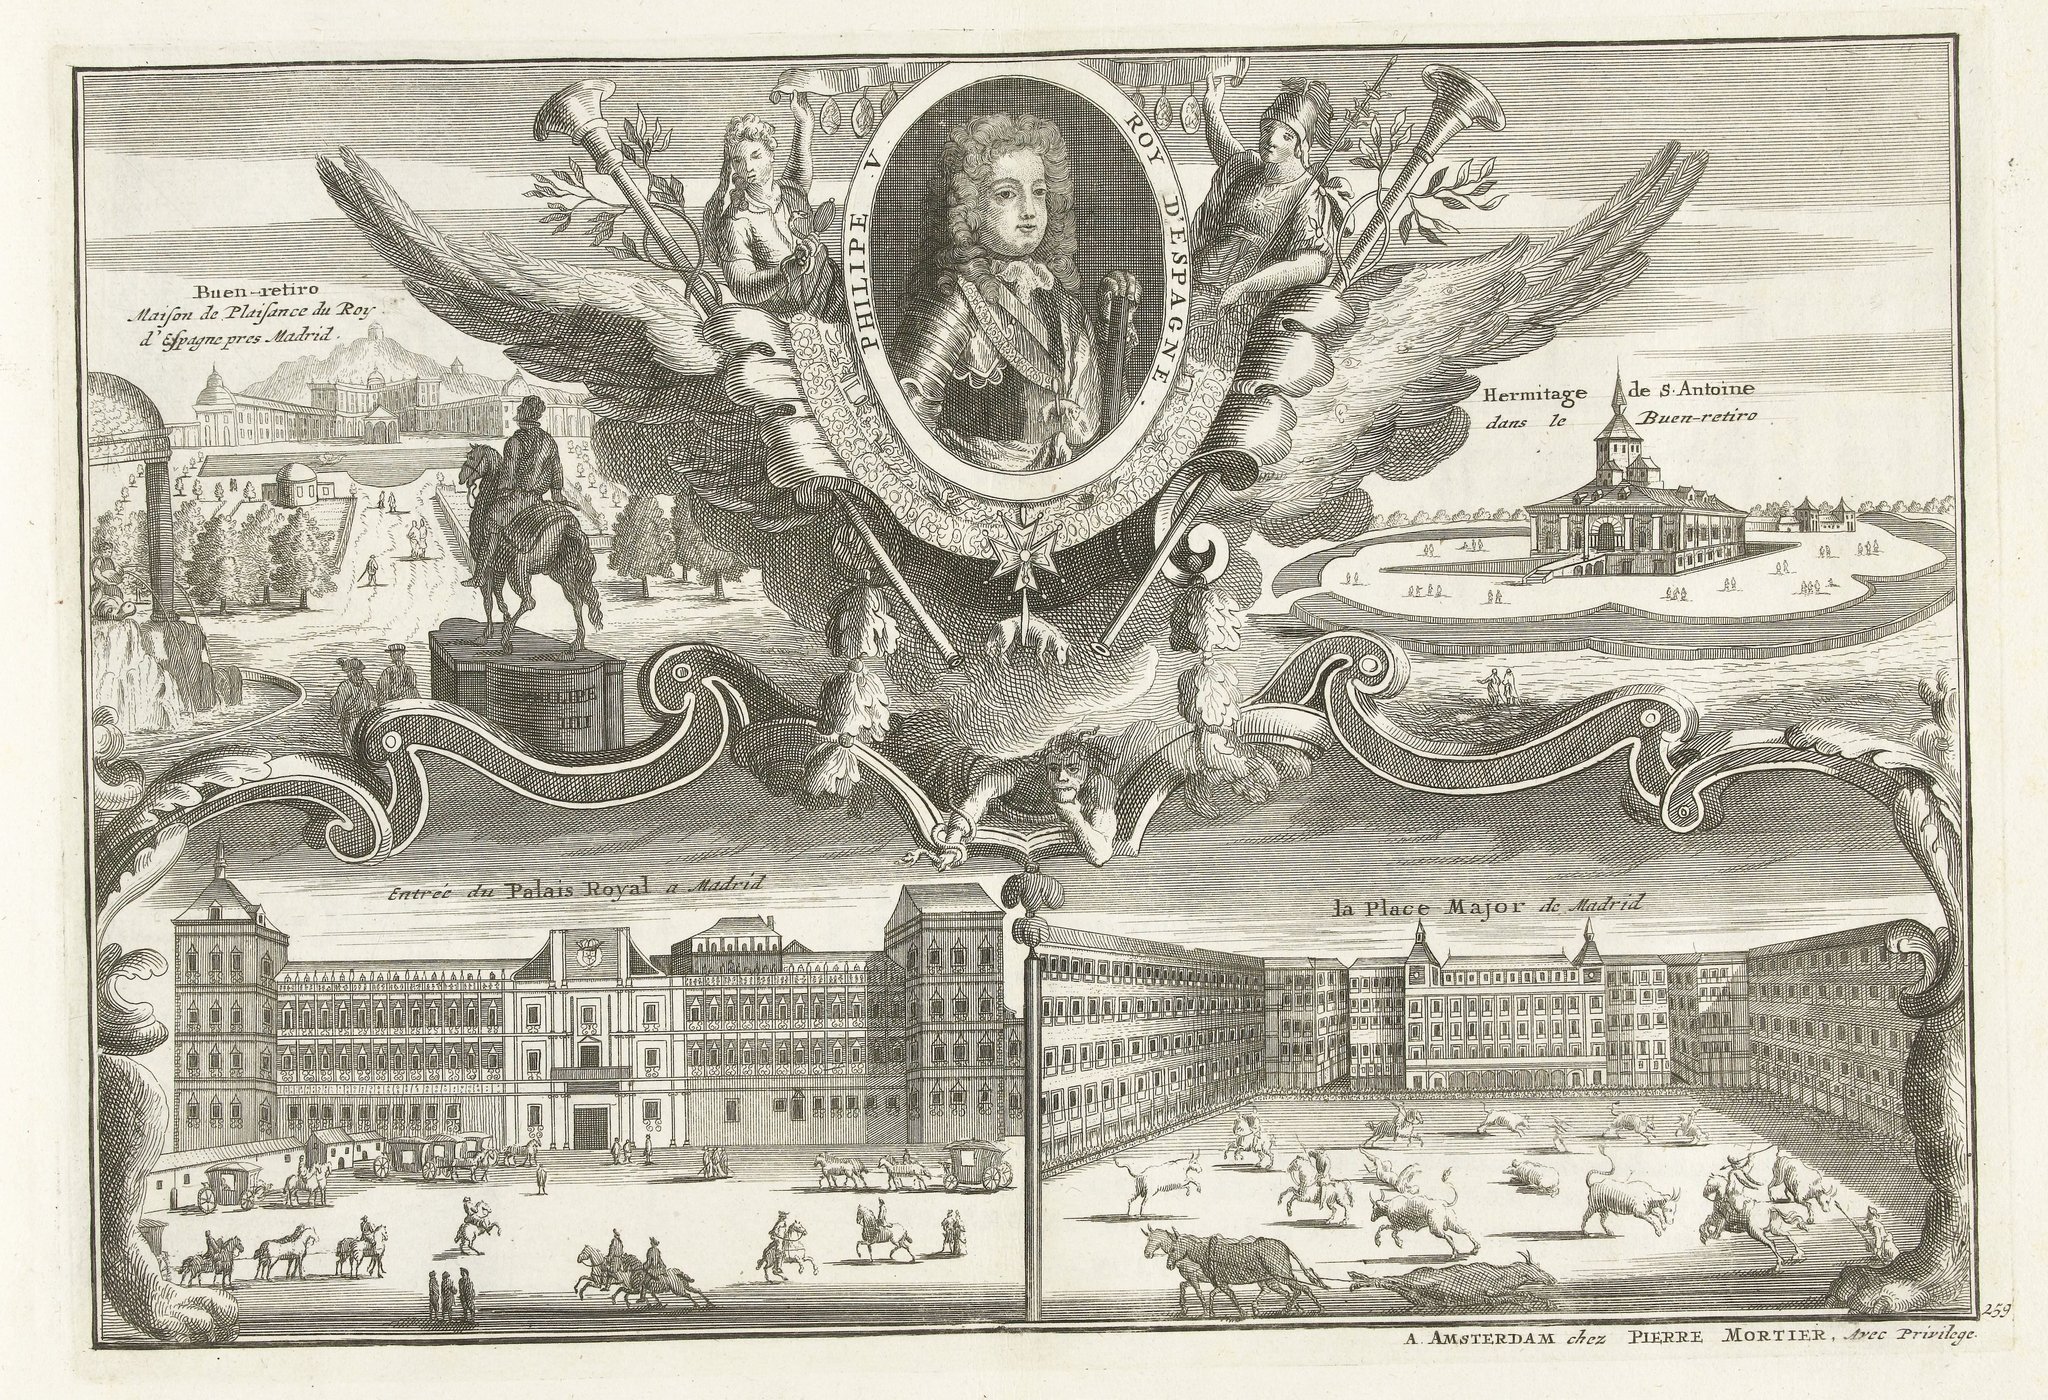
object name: print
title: Les Forces de l'Europe, Asie, Afrique et Amerique, ou description des principales villes avec leurs fortifications. Dessignées par les meilleurs ingenieurs, particulierement celles qui sont sous la domination de la France (...) et ornées de plusieurs superbes edifices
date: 1702-1703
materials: paper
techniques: etching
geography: amsterdam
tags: filips v (koning van spanje), palace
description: Gezicht op het Koninklijk Paleis en enkele andere bezienswaardigheden te Madrid en een portret van koning Filips V. Plaat nr. 259 in het prentwerk bestaande in totaal uit 276 genummerde platen van vermaarde sterke steden en vestingen in het kader van de Spaanse Successieoorlog. Voor het merendeel zijn deze platen gekopieerd naar de anonieme Franse platen: in Les forces de l'Europe en in: Le theatre de la guerre, dans les Pays-Bas, beide oorspronkelijk uitgegeven door Nicolas de Fer te Parijs (1693-1697) in het kader van de Negenjarige Oorlog. Titel en opschriften in de plaat in het Frans.